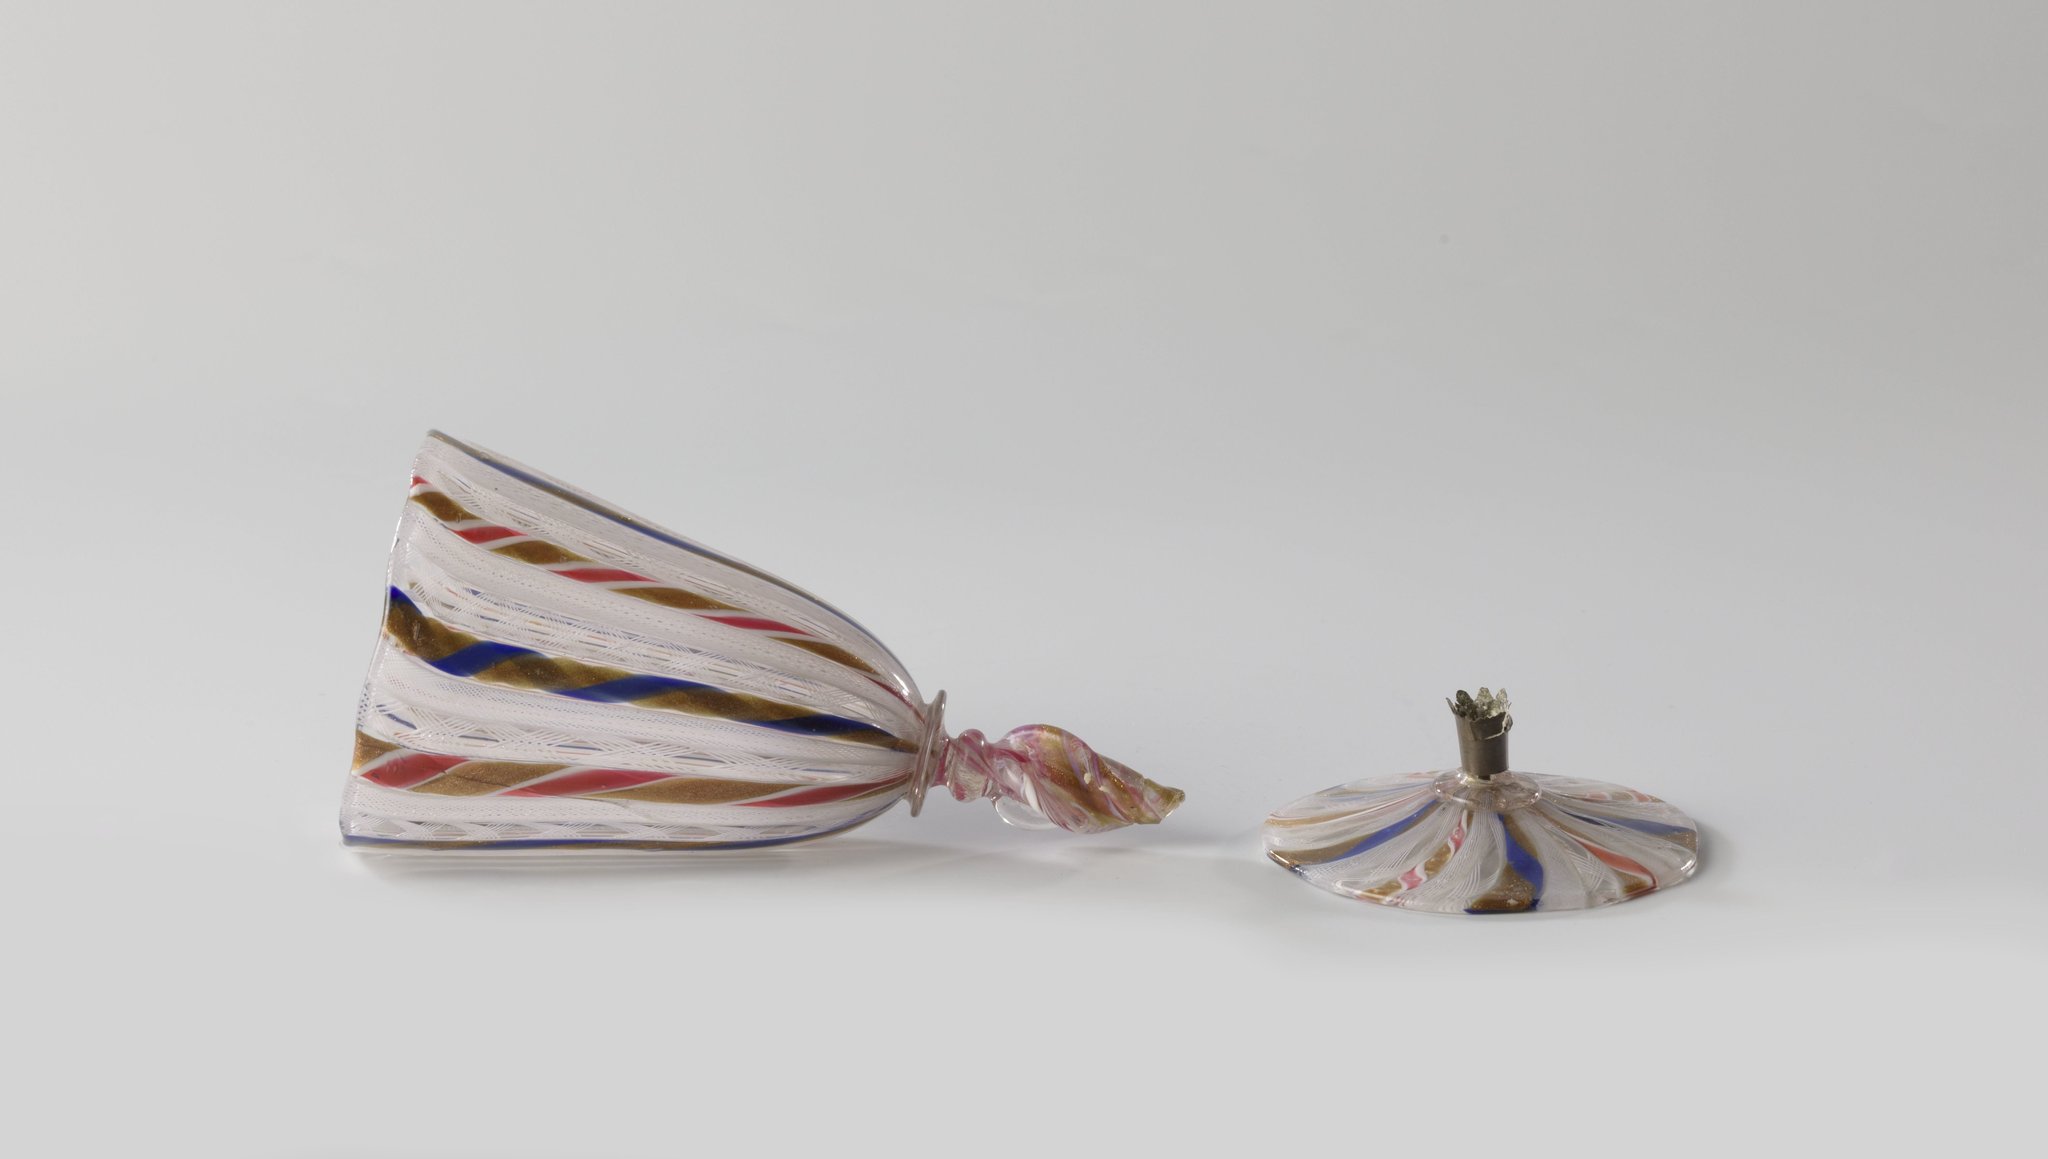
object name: goblet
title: Kelk van een kelkglas van filigraanglas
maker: Anonymous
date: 1896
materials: glass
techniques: façon de venise, glassblowing, vetro a retorti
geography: venice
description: Trechtervormige, aan de onderzijde afgeronde kelk van filigraanglas a fili en a retortoli. De voet is afgebroken (BK-NM-10754-18-A).